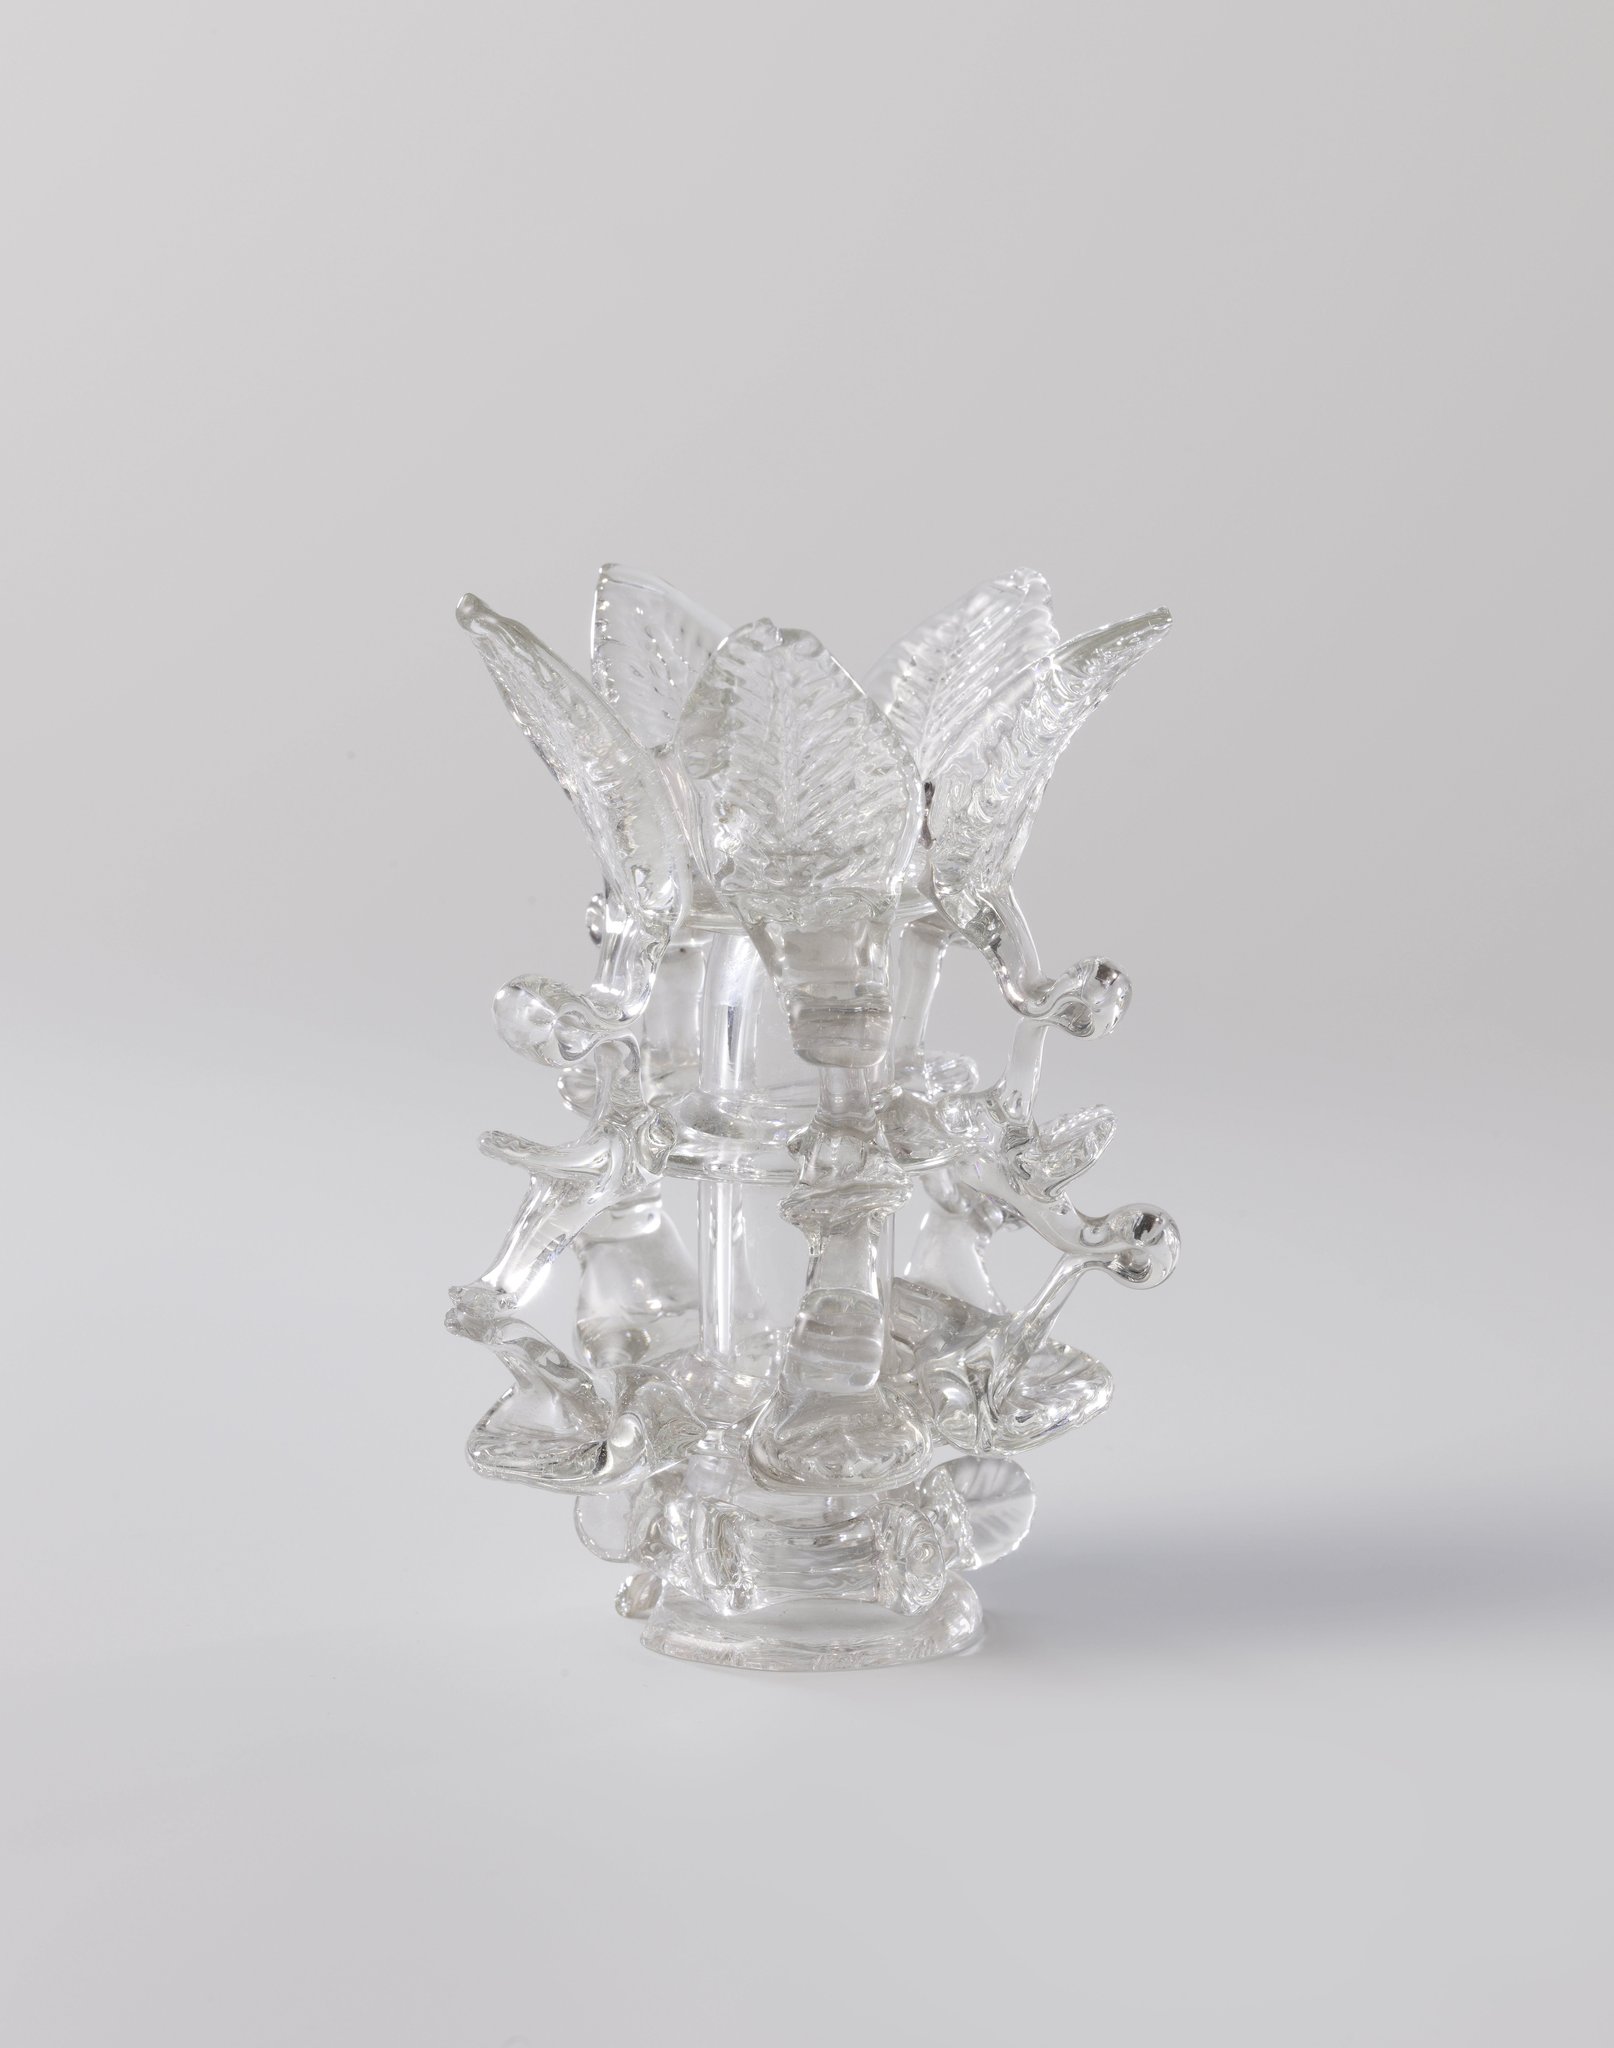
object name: kandelaar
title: Kandelaar (?)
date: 1700-1800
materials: glass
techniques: glassblowing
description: Hoge voet, opgebouwd uit vijf akanthusbladeren. Holle stam met twee ringen en een schijf. Verticaal langs de stam vijf in lussen gelegde, gladde draden. Een geknepen draad langs de bovenrand.